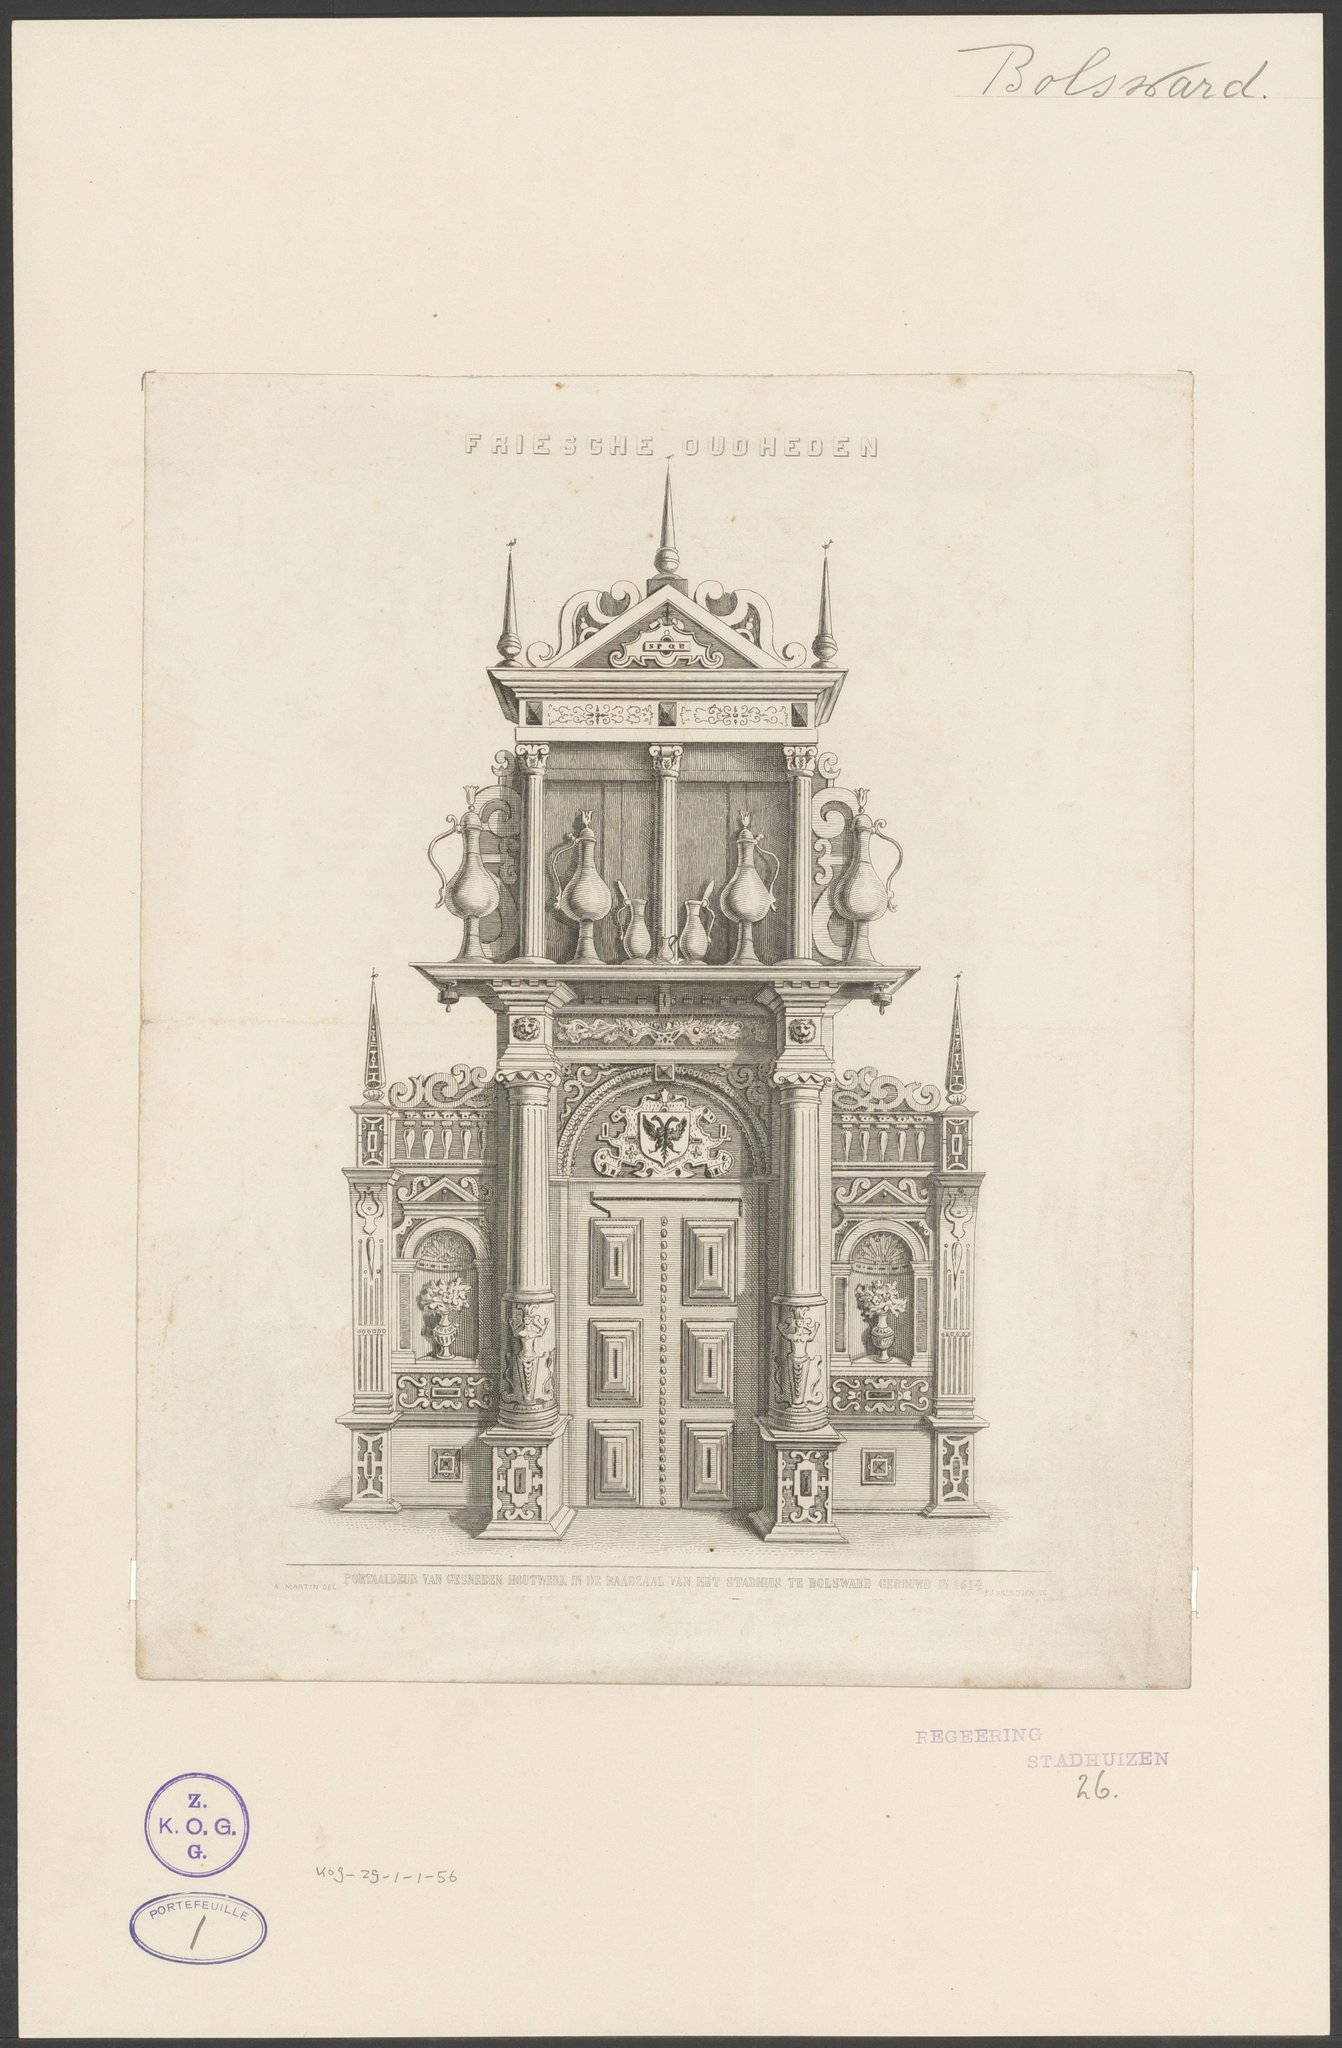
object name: reclameplaat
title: Friesche Oudheden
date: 1808-1871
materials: paper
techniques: lithograph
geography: netherlands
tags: monumental door, porch, 'aediculum', townhall, piece of sculpture, reproduction of a piece of sculpture, wood carver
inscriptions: collector's mark, collector's mark: Lugt 1641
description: Deur met houtsnijwerk, in het stadhuis van Bolsward. Op de achterzijde tekst waarin door de uitgever reclame gemaakt wordt voor de serie Friesche Oudheden uitgegeven in samenwerking met het Friesch Genootschap. Onderwerpsrubrieken binnen de Atlas Zeden en Gewoonten: Regeering, Stadhuizen (B-D).